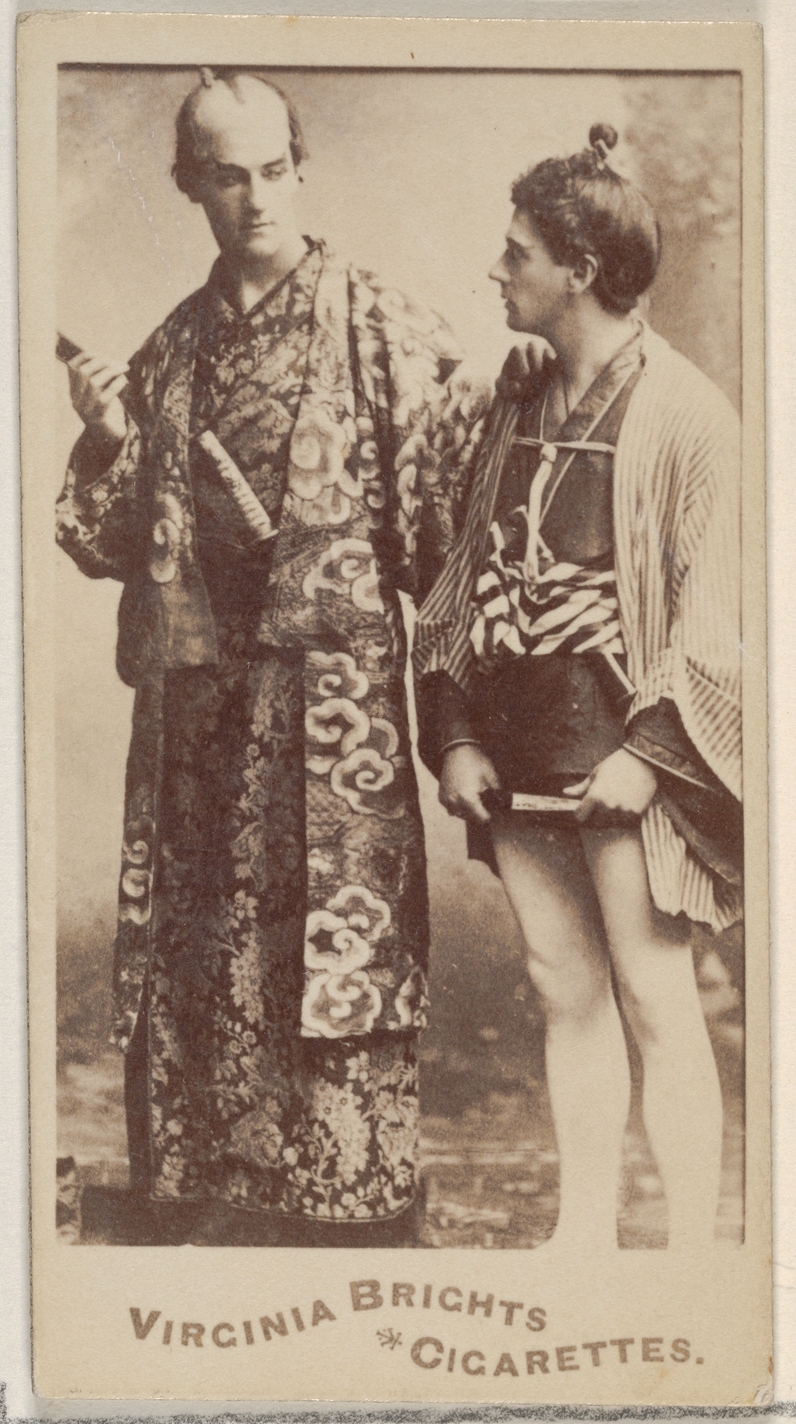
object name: photograph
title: From the Actors and Actresses series (N45, Type 5) for Virginia Brights Cigarettes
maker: allen & ginter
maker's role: publisher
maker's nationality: american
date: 1888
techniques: albumen silver print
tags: men,actors